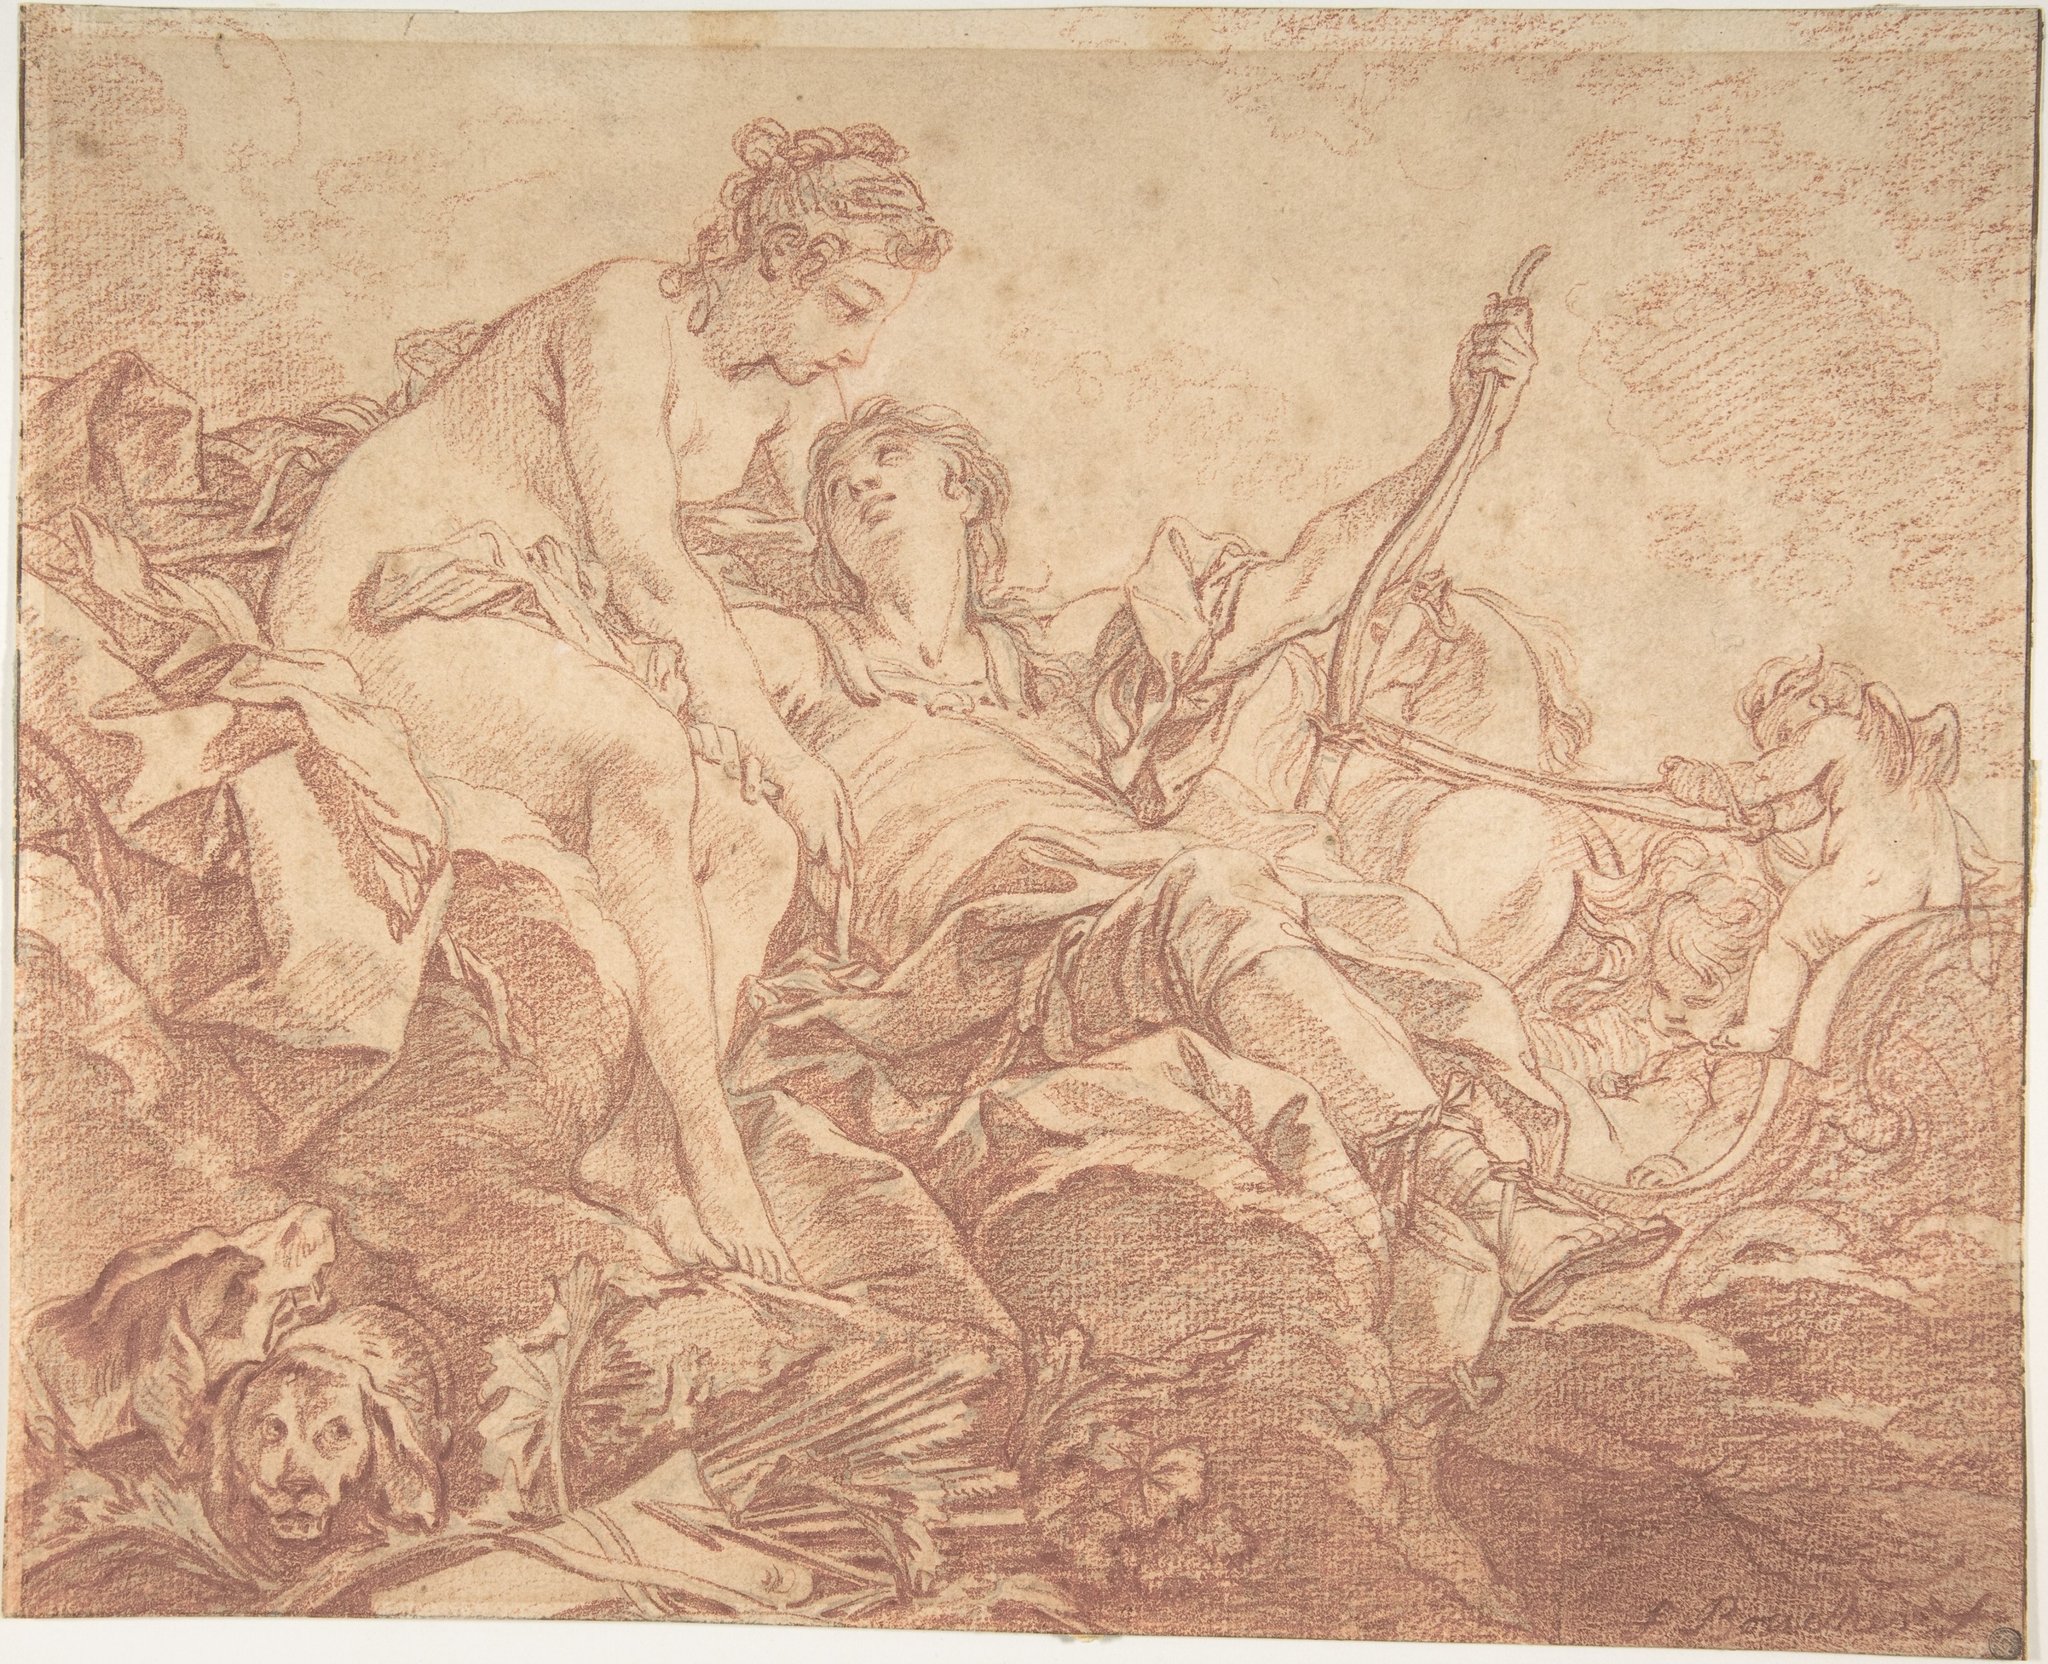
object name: drawing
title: Aurora and Cephalus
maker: françois boucher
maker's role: artist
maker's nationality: french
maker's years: 1703-1770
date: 1734-1766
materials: chalk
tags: men,female nudes,putti,dogs,horses